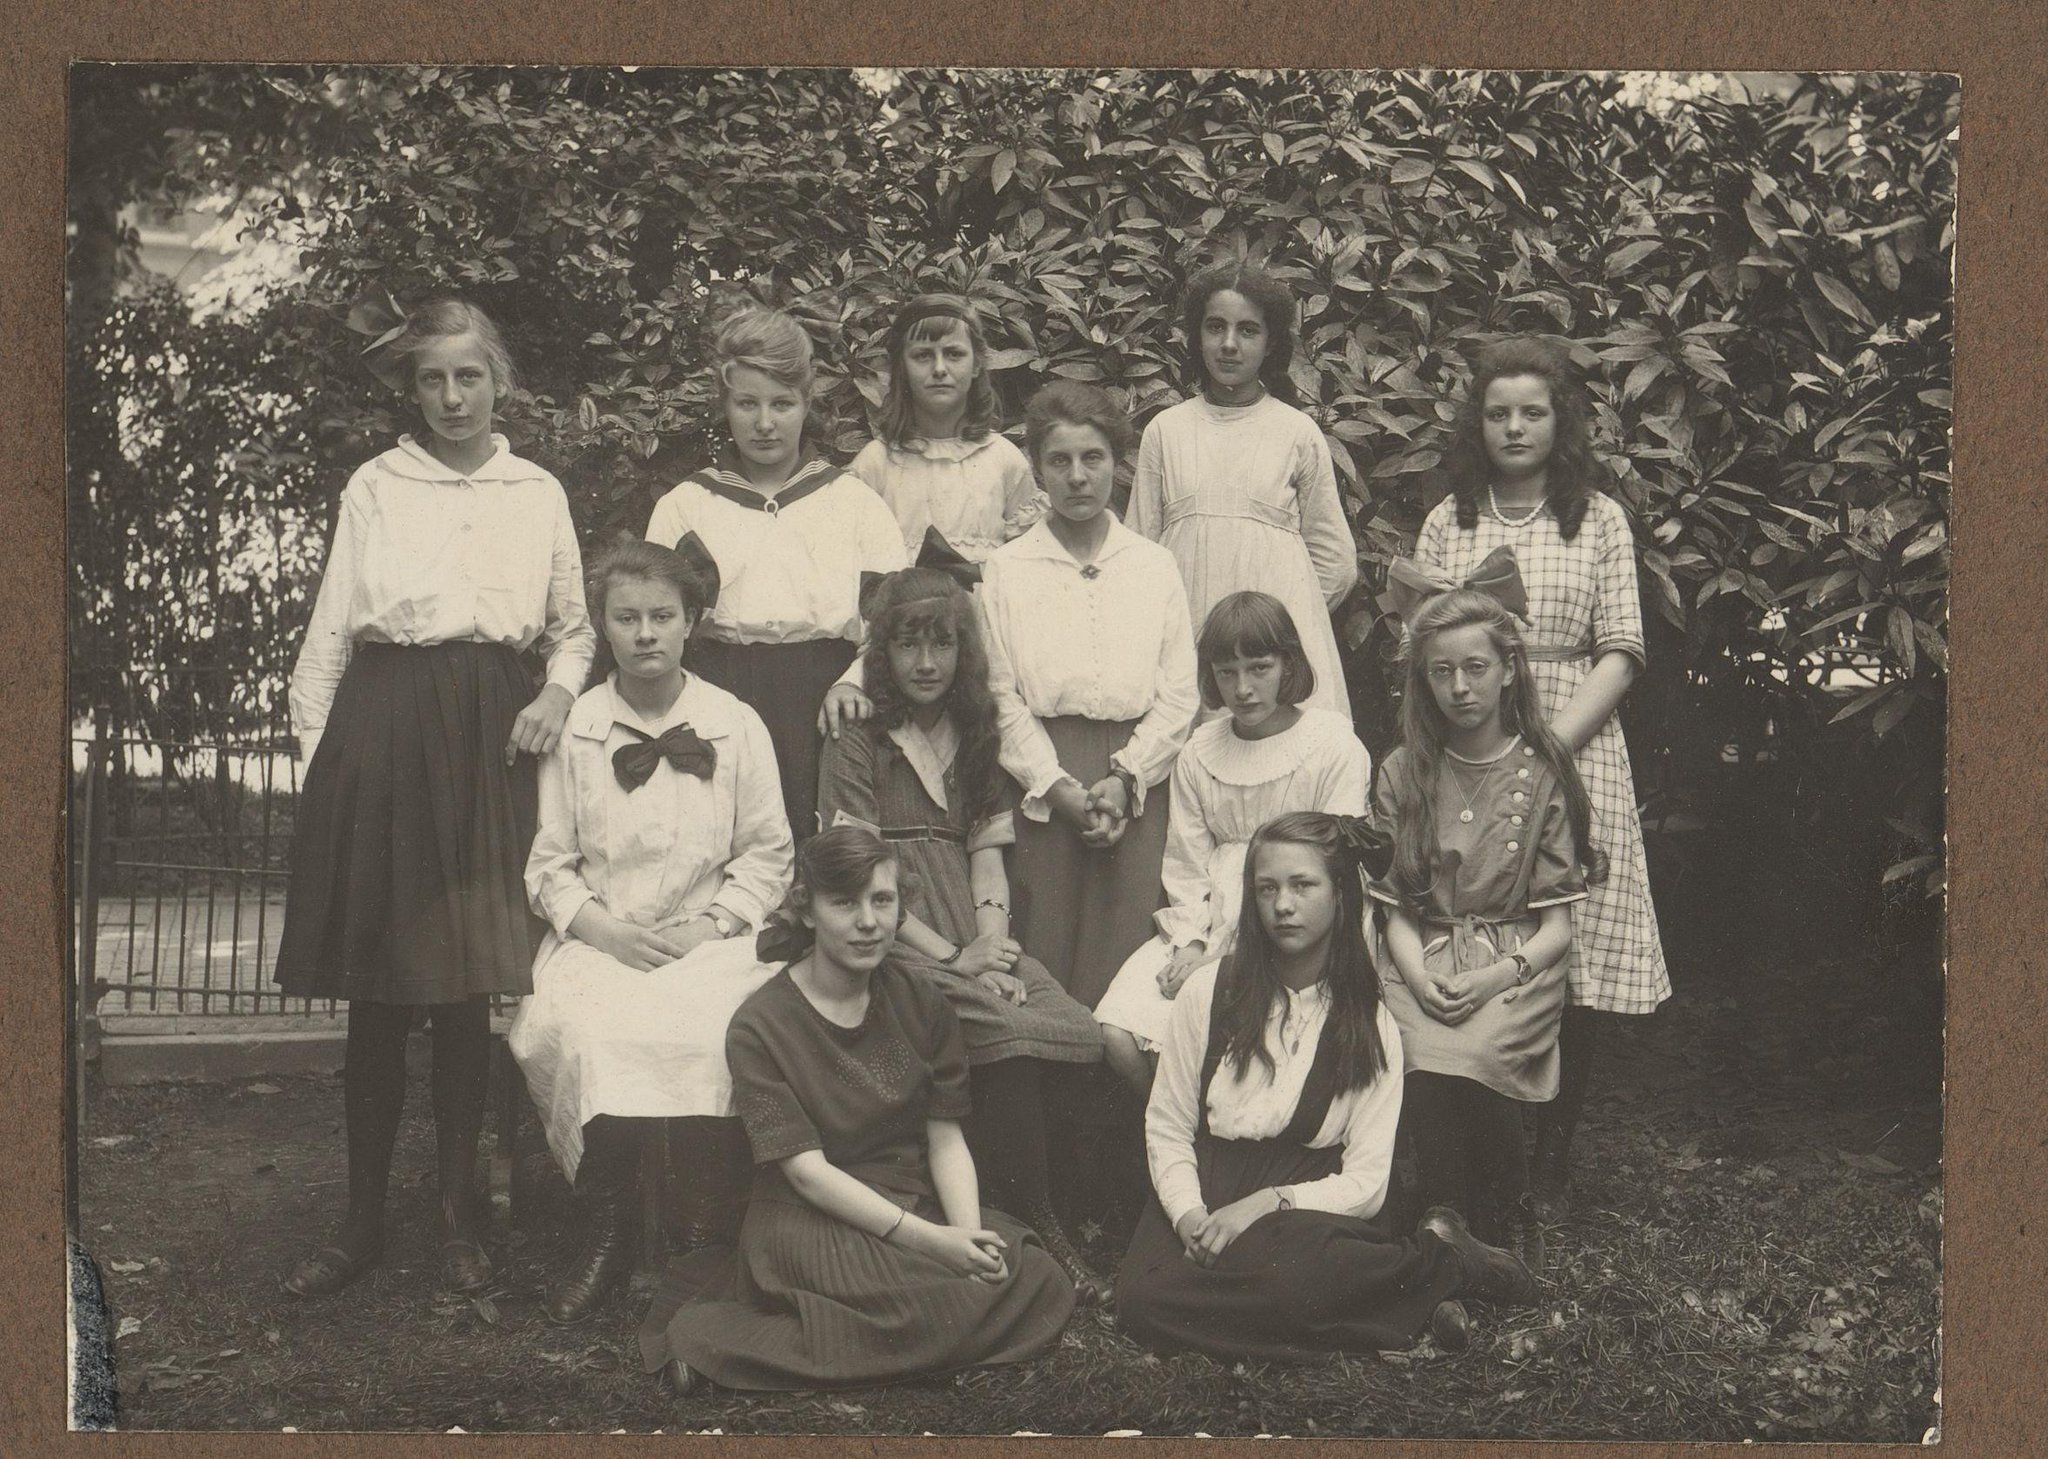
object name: photograph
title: Groepsportret van jonge vrouwen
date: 1870-1920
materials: photographic support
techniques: photography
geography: netherlands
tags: netherlands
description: Foto op bruin albumblad 41 van familiealbum van Alphons Diepenbrock.